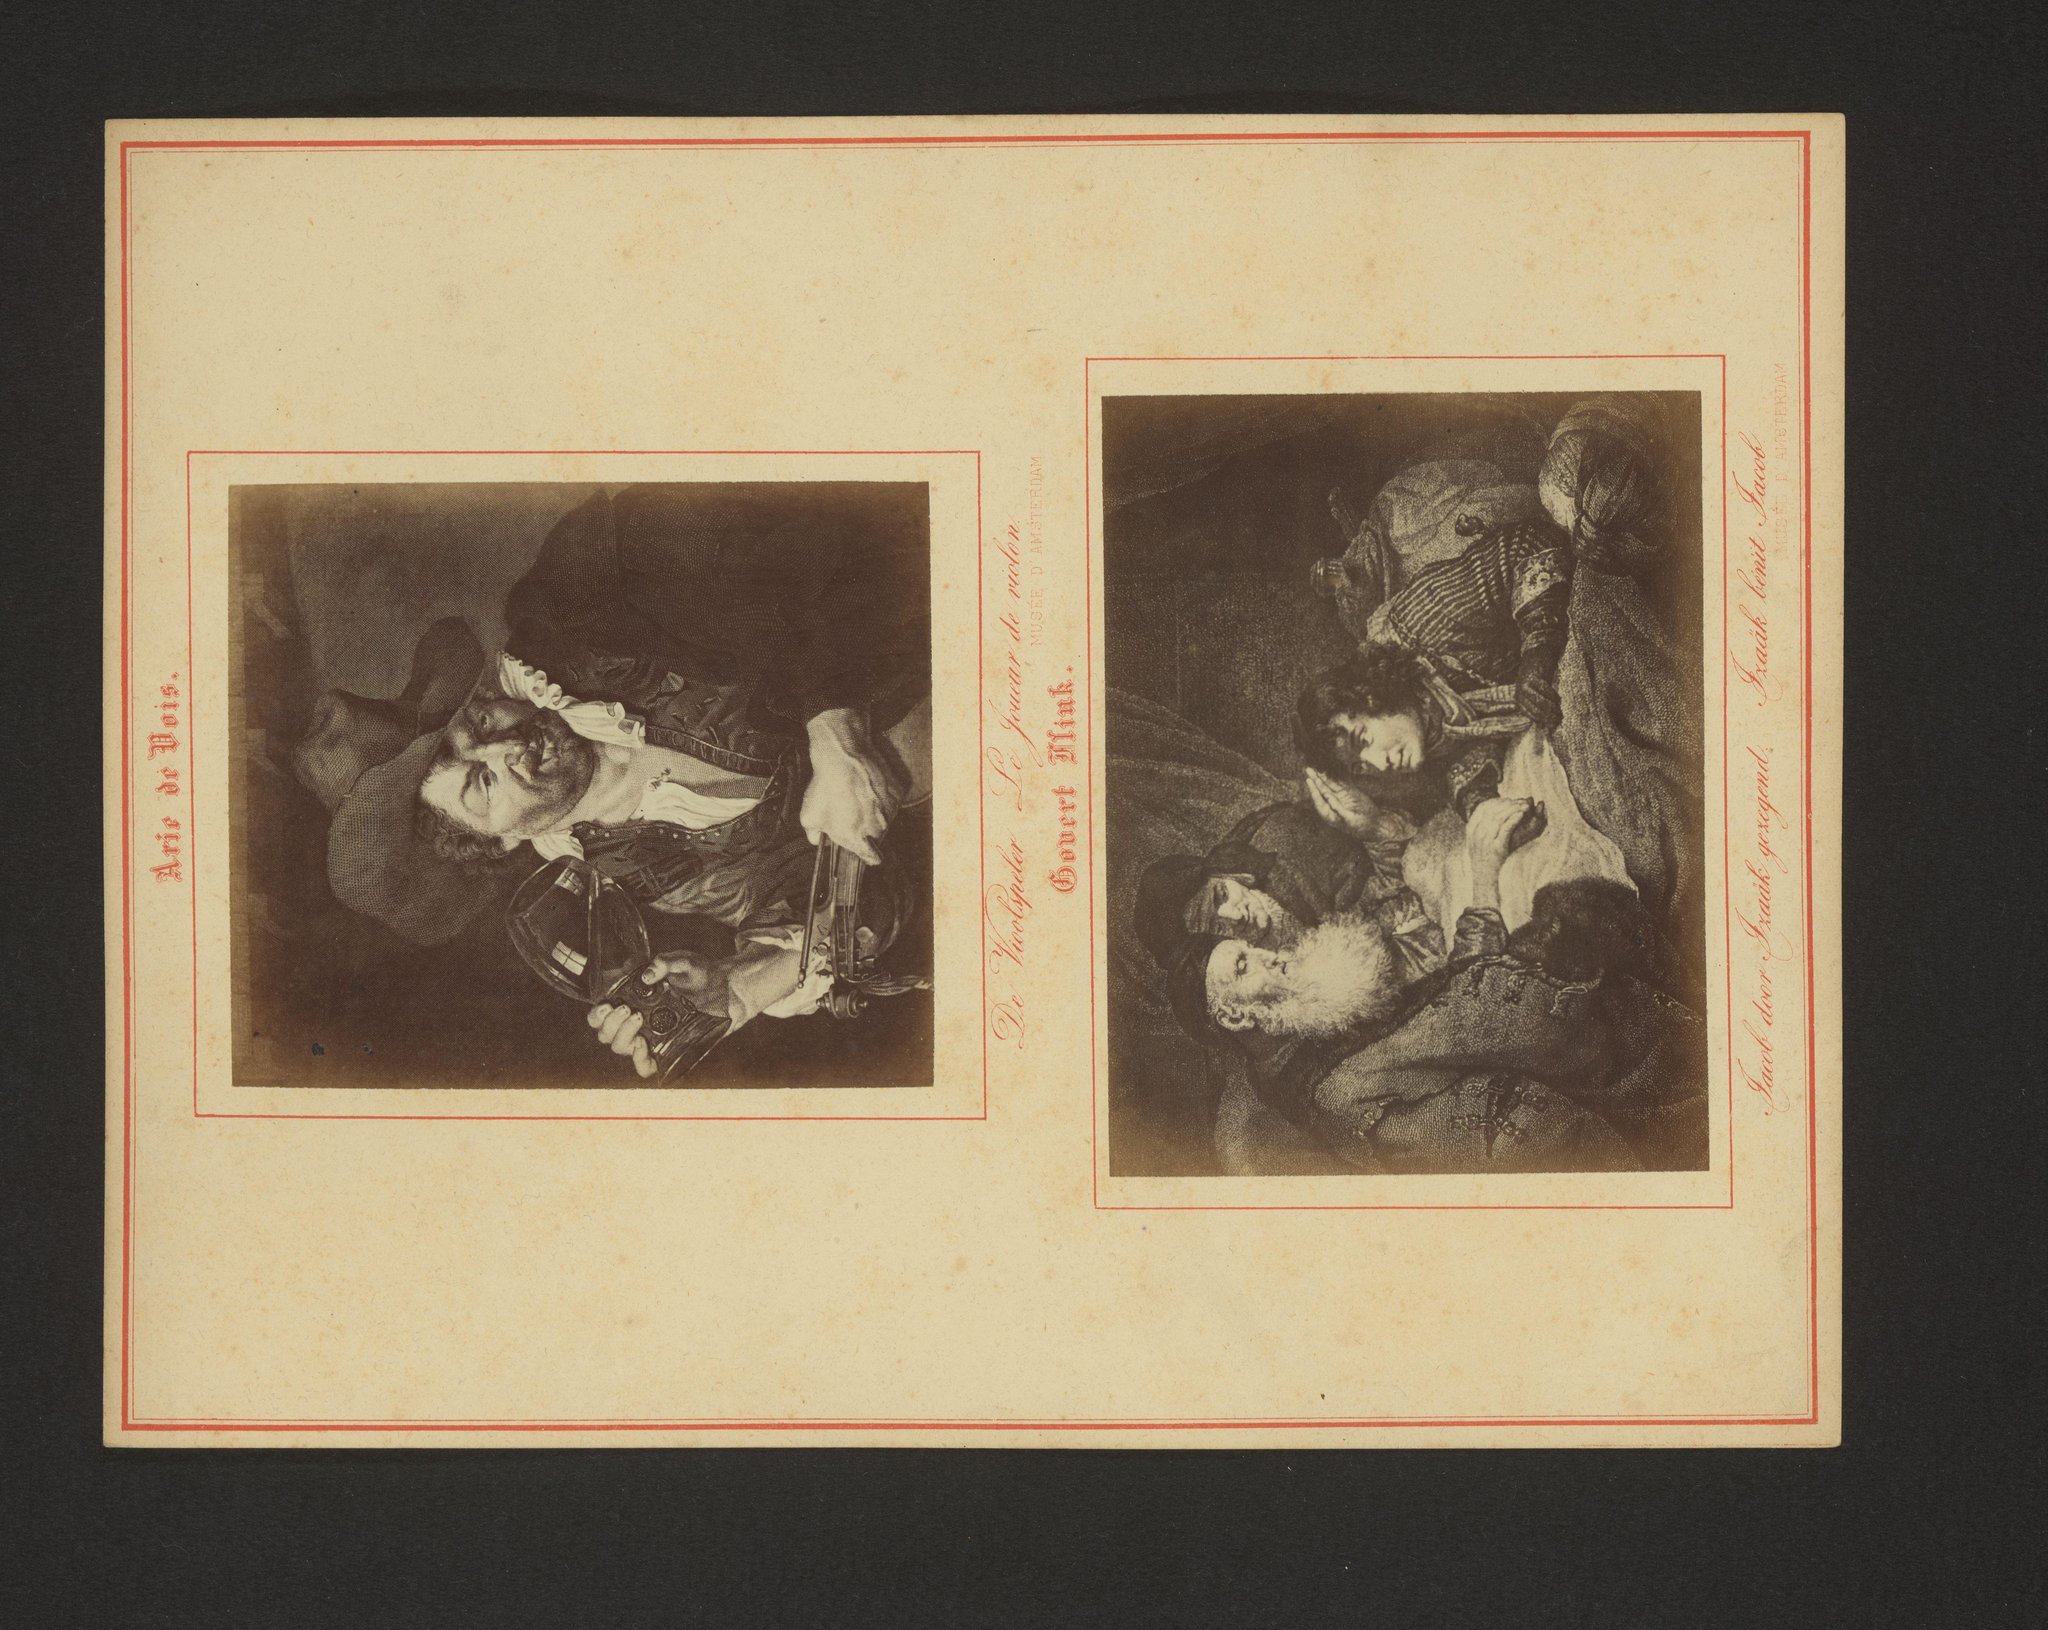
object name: photograph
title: Govert Flinck - Jacob door Izaak gezegd, Izaäk bénit Jacob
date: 1866-1874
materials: cardboard, photographic support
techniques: albumen print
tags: historical persons, violin, fiddle, glass, rummer, isaac sitting in bed blesses jacob who, disguised in esau's clothes, brings food to his father; jacob's hands and neck are covered with goatskins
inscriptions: annotation: ‘Musée d'Amsterdam’, annotation: ‘Musée d'Amsterdam’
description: Deze foto maakt deel uit van een omslag met 25 foto's.